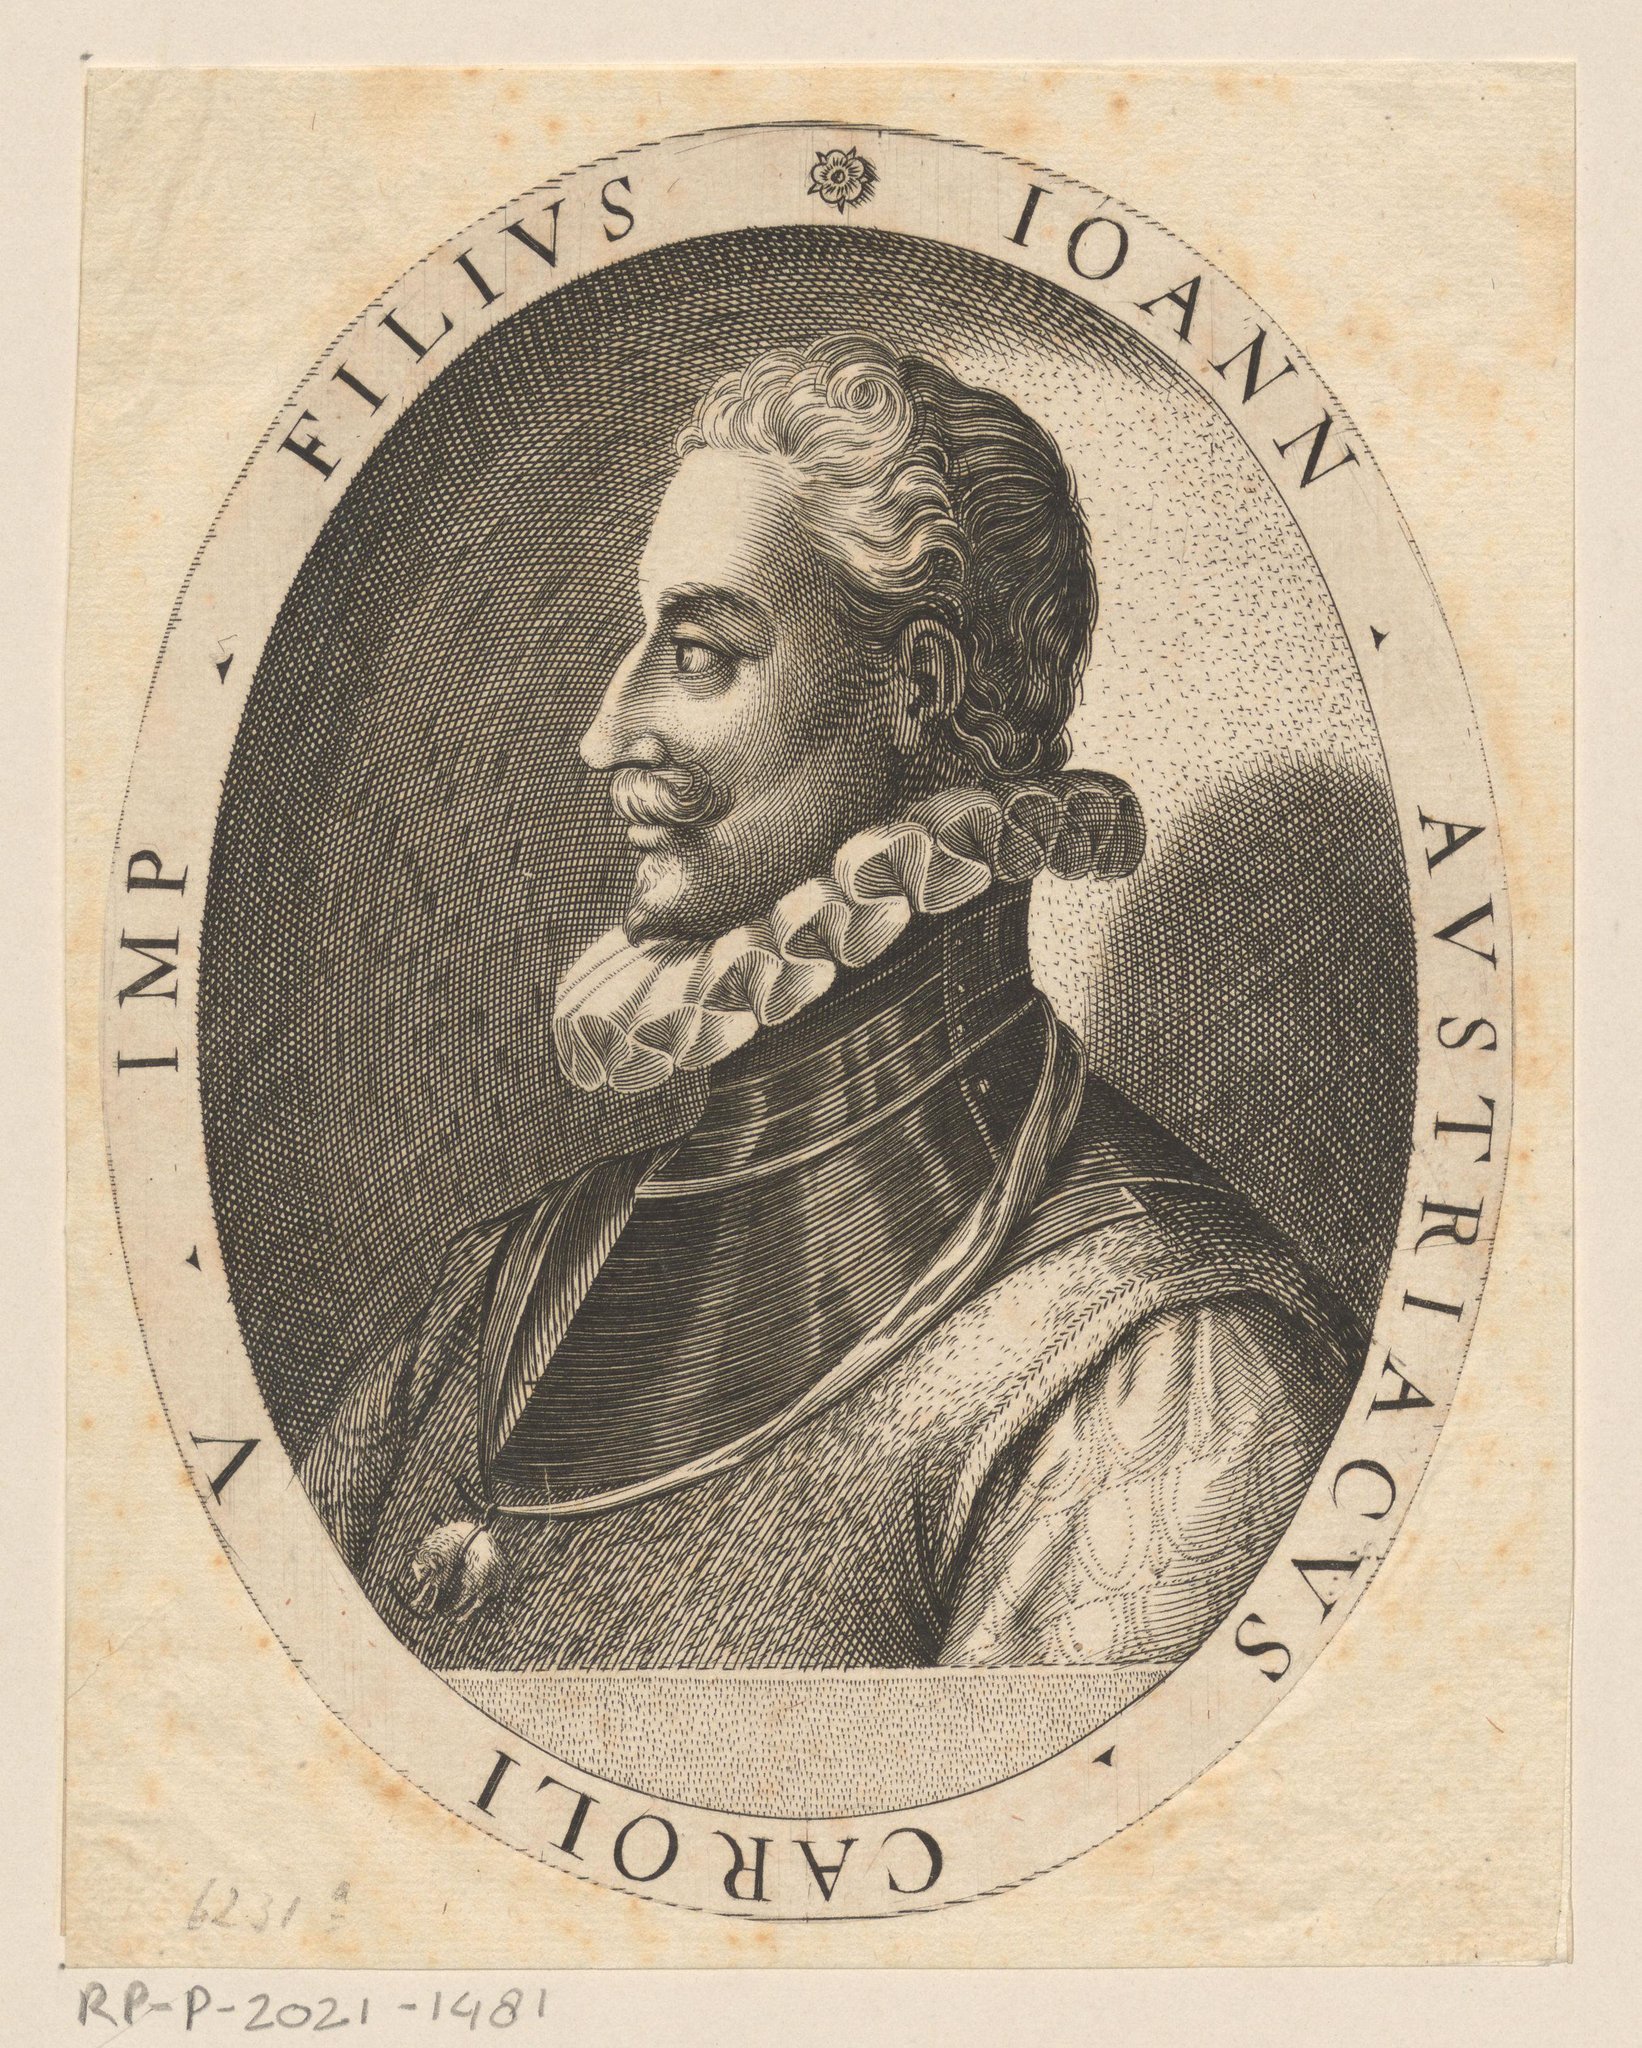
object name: print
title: Atrium Heroicum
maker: dominicus custos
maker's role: print maker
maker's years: 1560-1615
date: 1600-1604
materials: paper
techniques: engraving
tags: don juan van oostenrijk, historical persons, knighthood order of the golden fleece, ruler, sovereign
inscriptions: collector's mark: Lugt 1337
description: Prent komt vermoedelijk uit 'Atrium Heroicum'. De serie werd tussen 1600 en 1604 in vier delen uitgegeven.